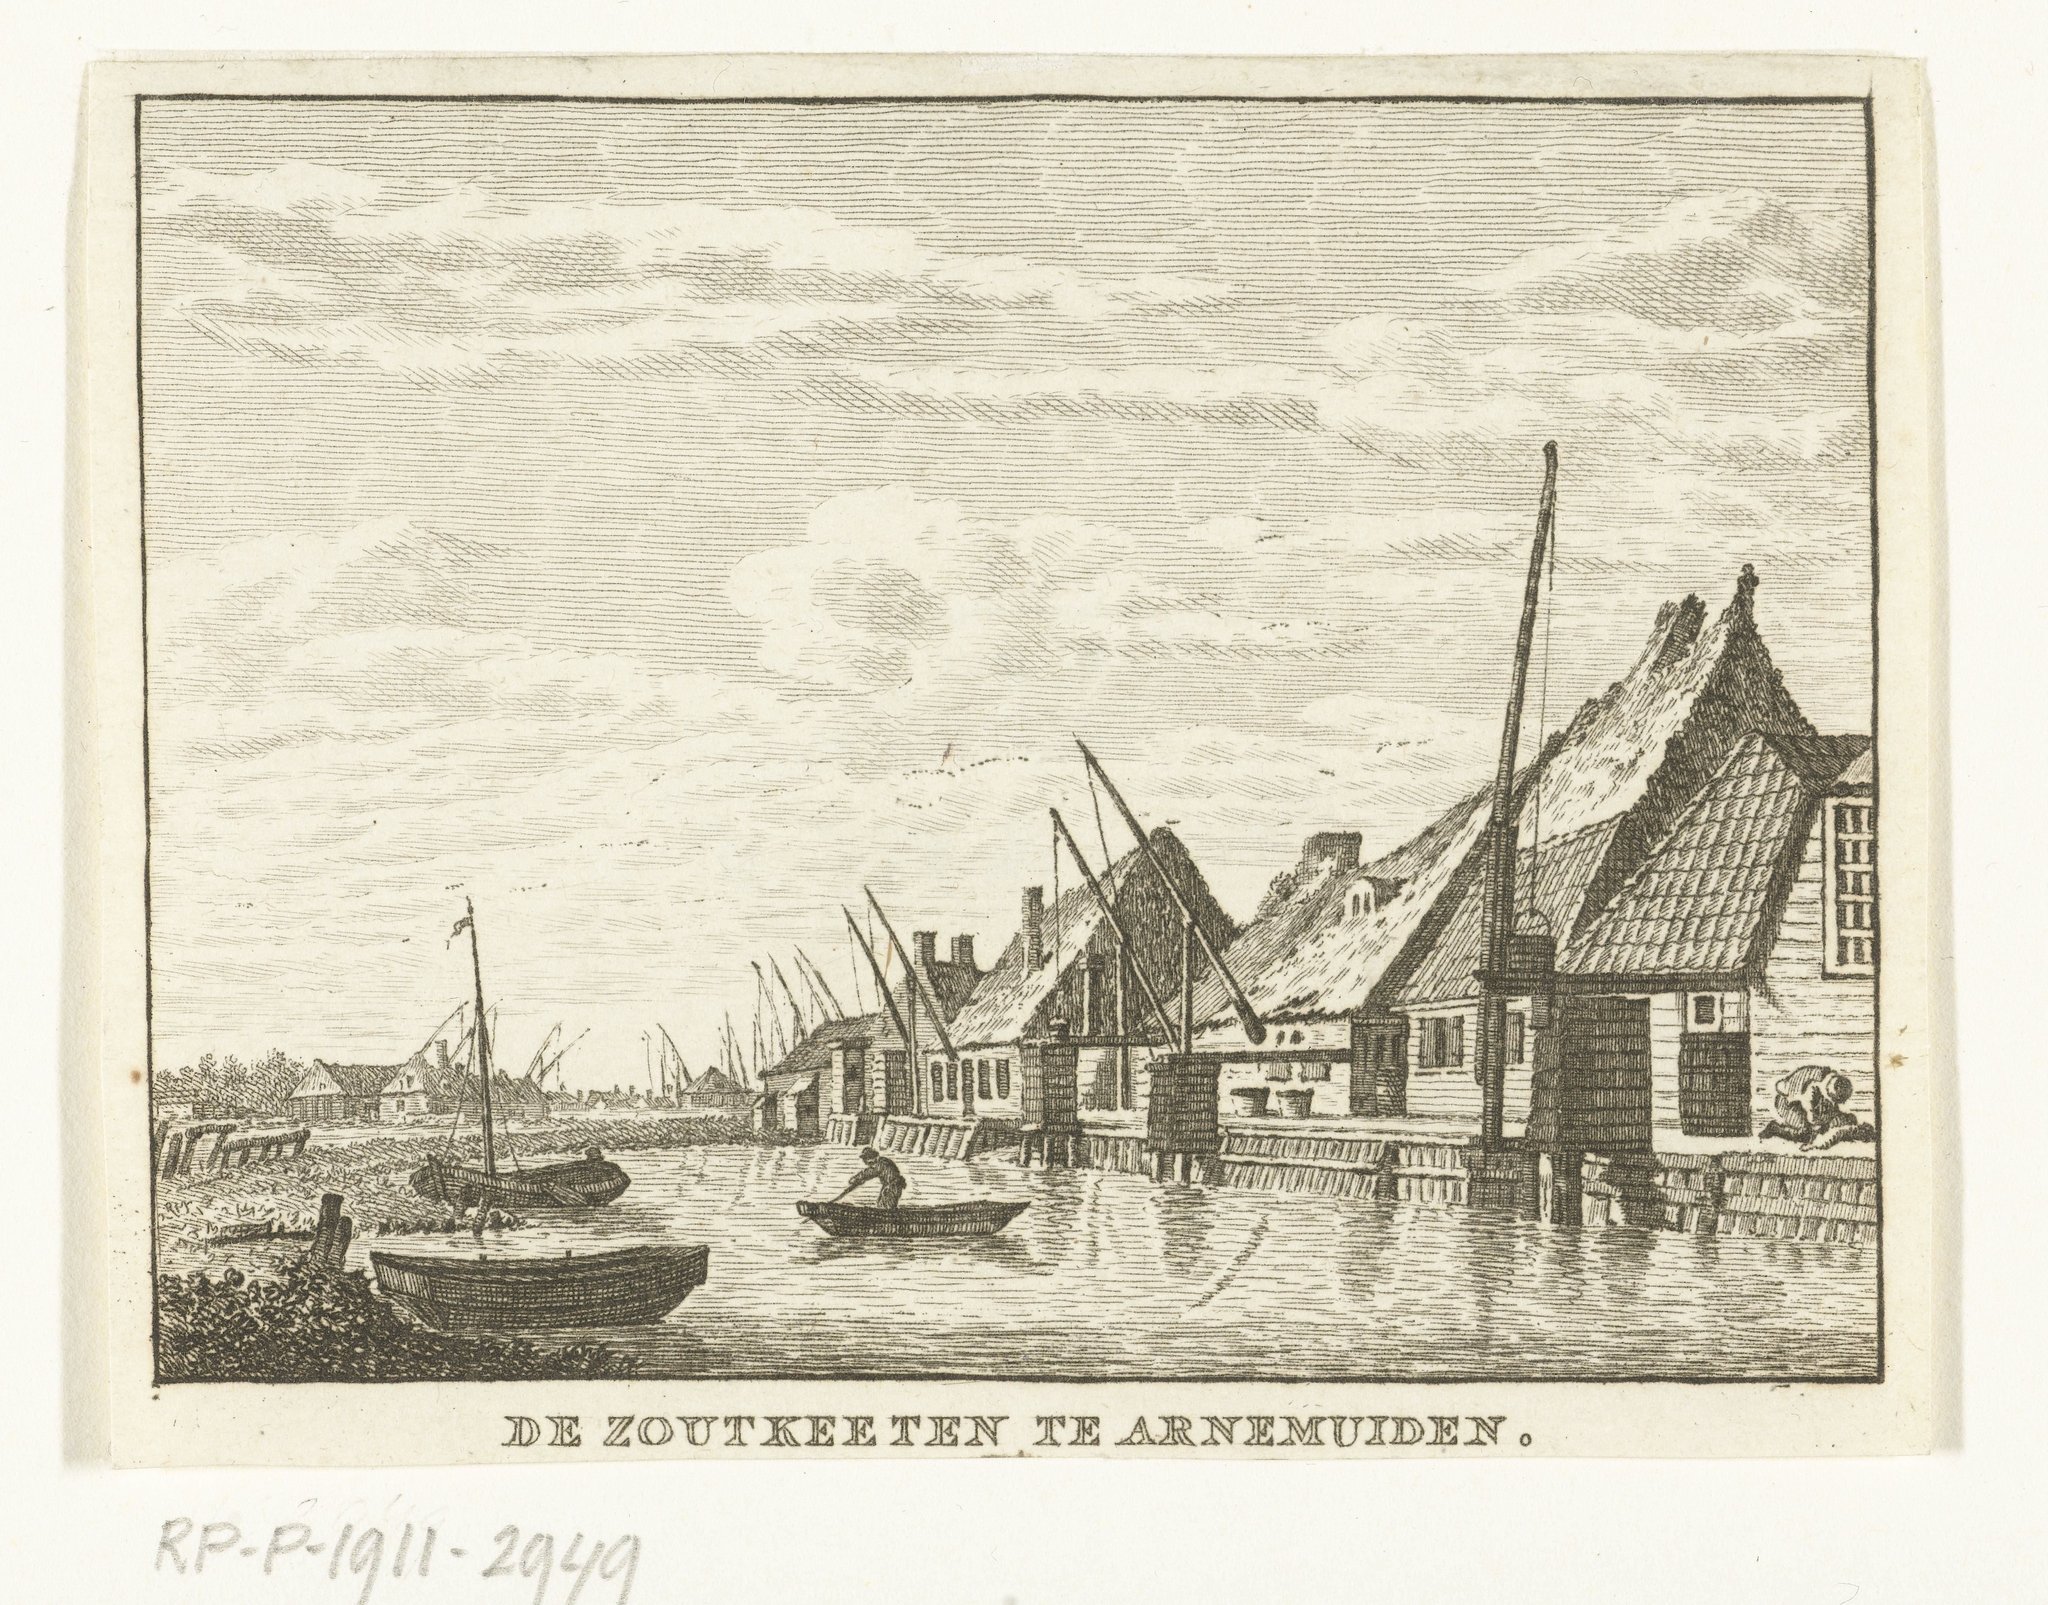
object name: print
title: De zoutkeeten te Arnemuiden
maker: carel frederik bendorp (i)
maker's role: print maker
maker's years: 1736-1814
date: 1786-1792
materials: paper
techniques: etching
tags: exterior of industrial structures, factories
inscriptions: collector's mark: Lugt 2228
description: Prent uit: Vaderlandsche gezichten, of afbeeldingen van den tegenwoordigen staat der Vereenigde Nederlanden (…). Amsterdam: Hendrik Gartman, Willem Vermandel en Jan Willem Smit, 1786-1792. Uitgegeven in afleveringen met ieder een eigen bifolium en inhoudsopgave. Alle prenten in deze publicatie zijn gegraveerd door Carel Frederik Bendorp (I) en, in de meeste gevallen, gebaseerd op tekeningen van Jan Bulthuis. Prent afgesneden van blad met twee voorstellingen.